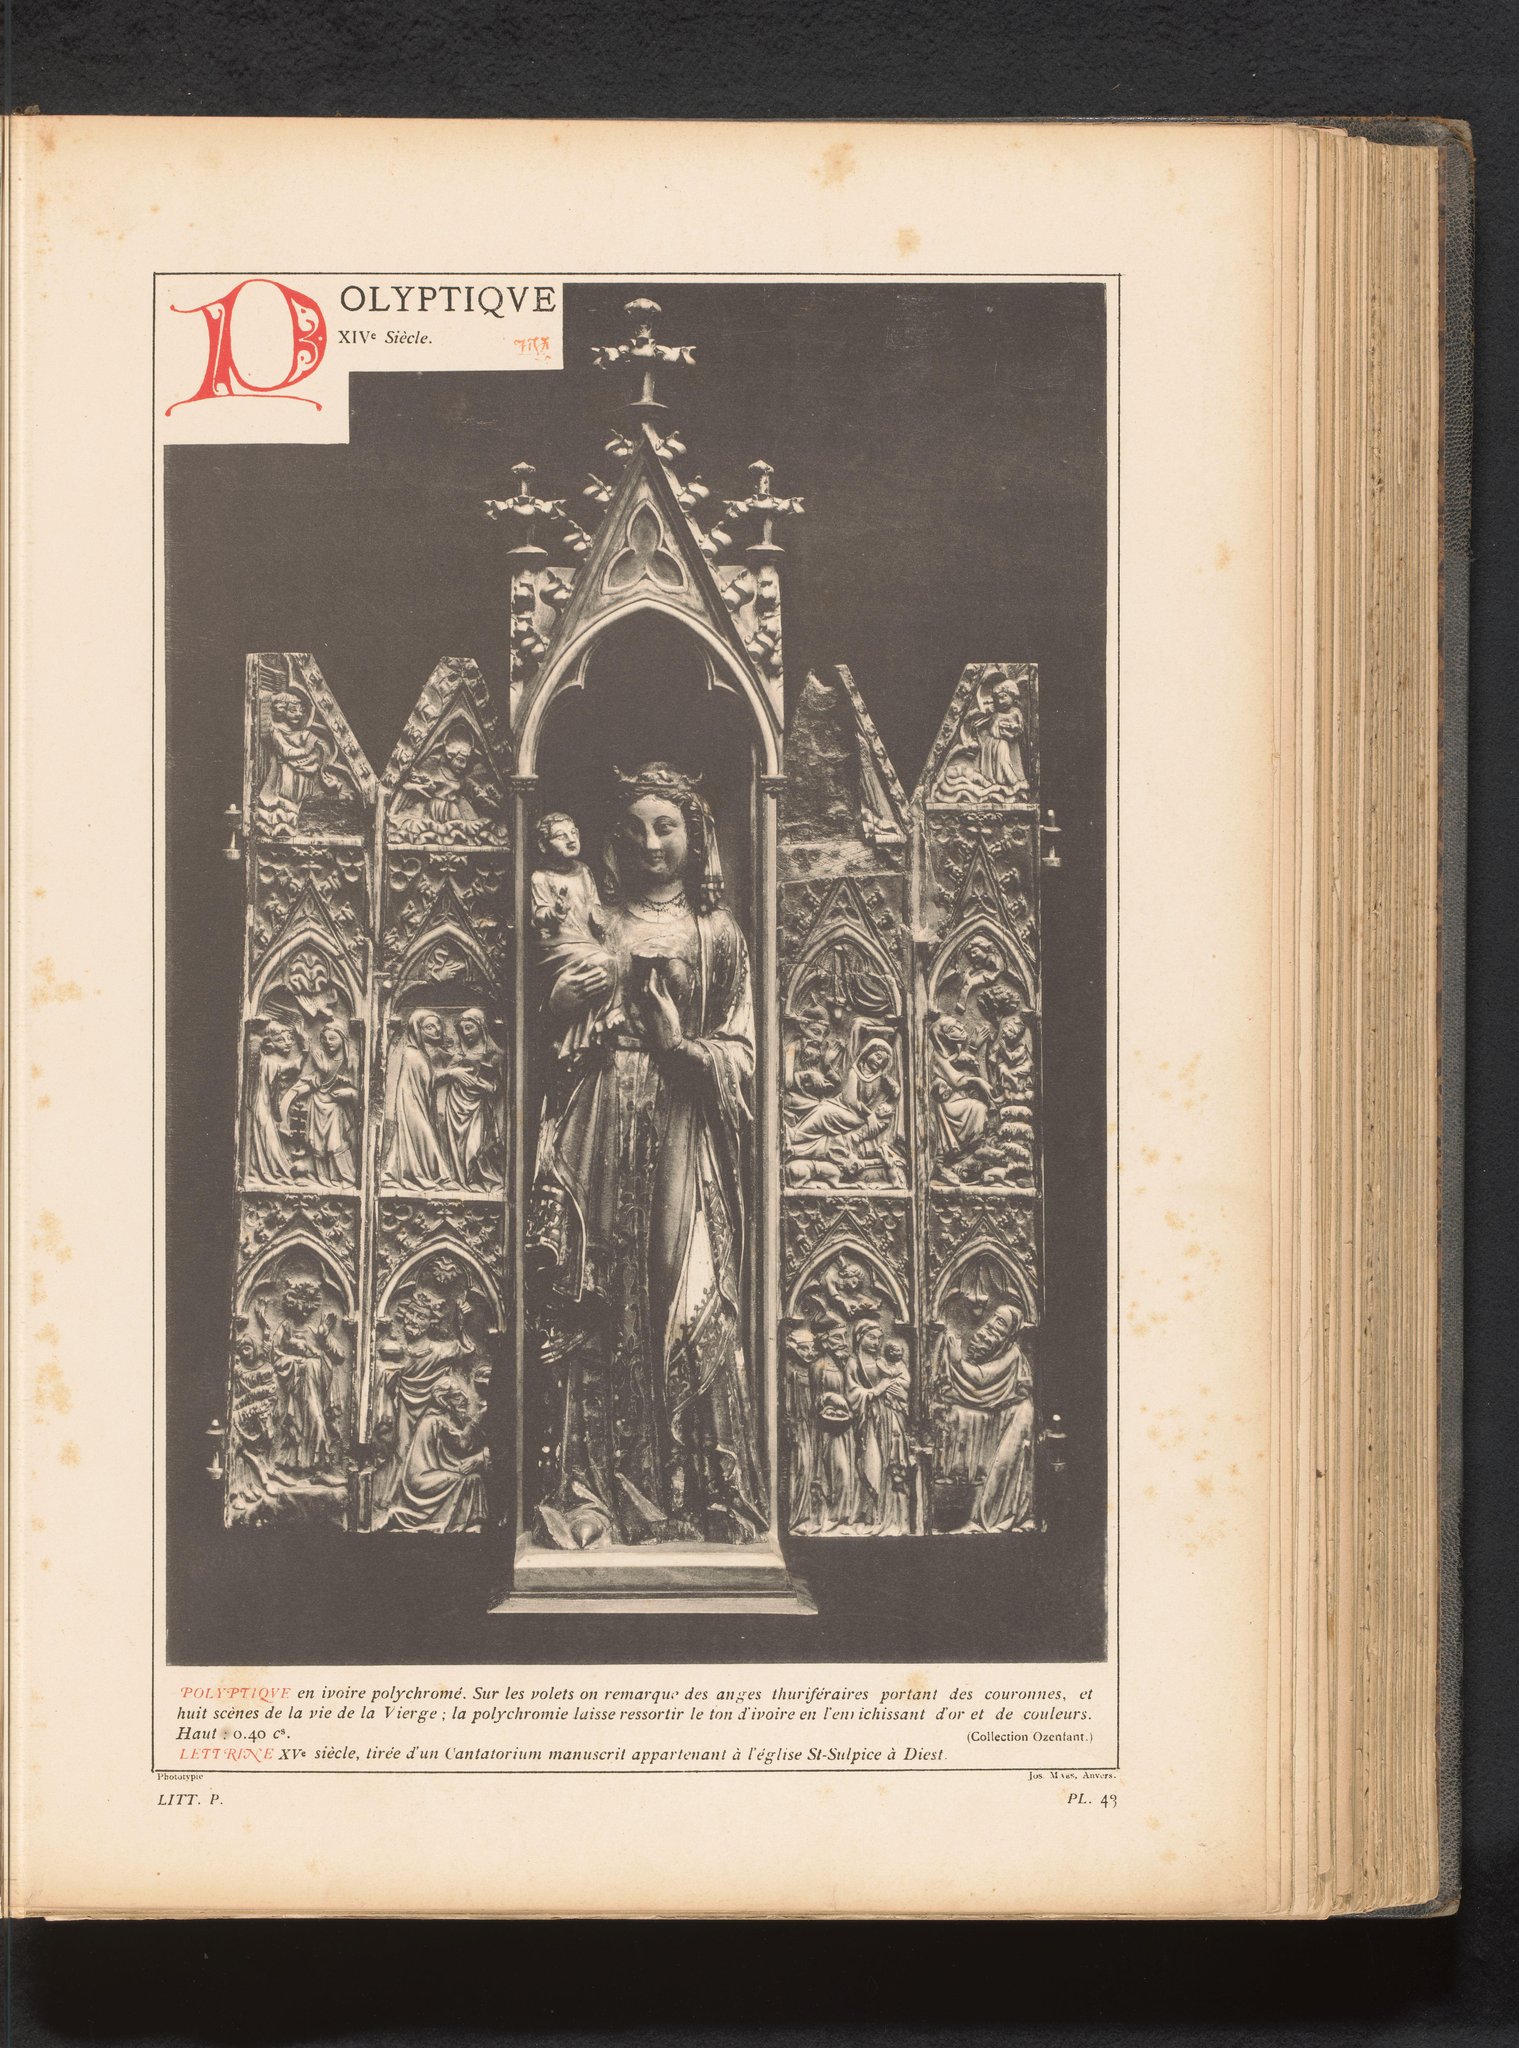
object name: page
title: Polyptiek met Bijbelse voorstellingen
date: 1876-1881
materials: paper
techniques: photograph, photolithography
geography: antwerp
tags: madonna: i.e. mary with the christ-child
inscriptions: inscription: ‘POLYPTYQUE en ivoire (...)’, monogram: ‘JJvY’, inscription: ‘LITT. P. - PL. 43.’